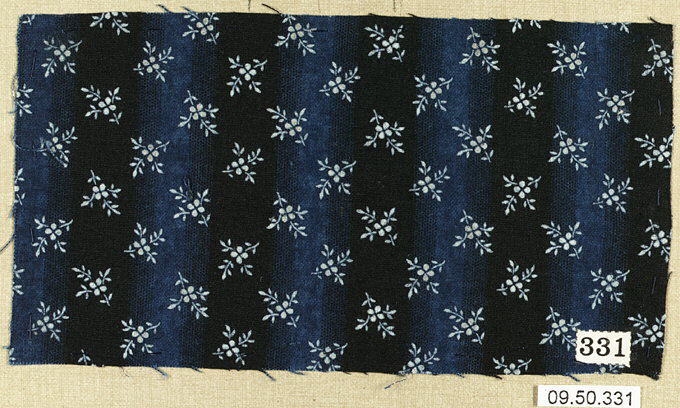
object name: piece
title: Piece (one of 116)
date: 1801-1900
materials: cotton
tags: flowers,leaves